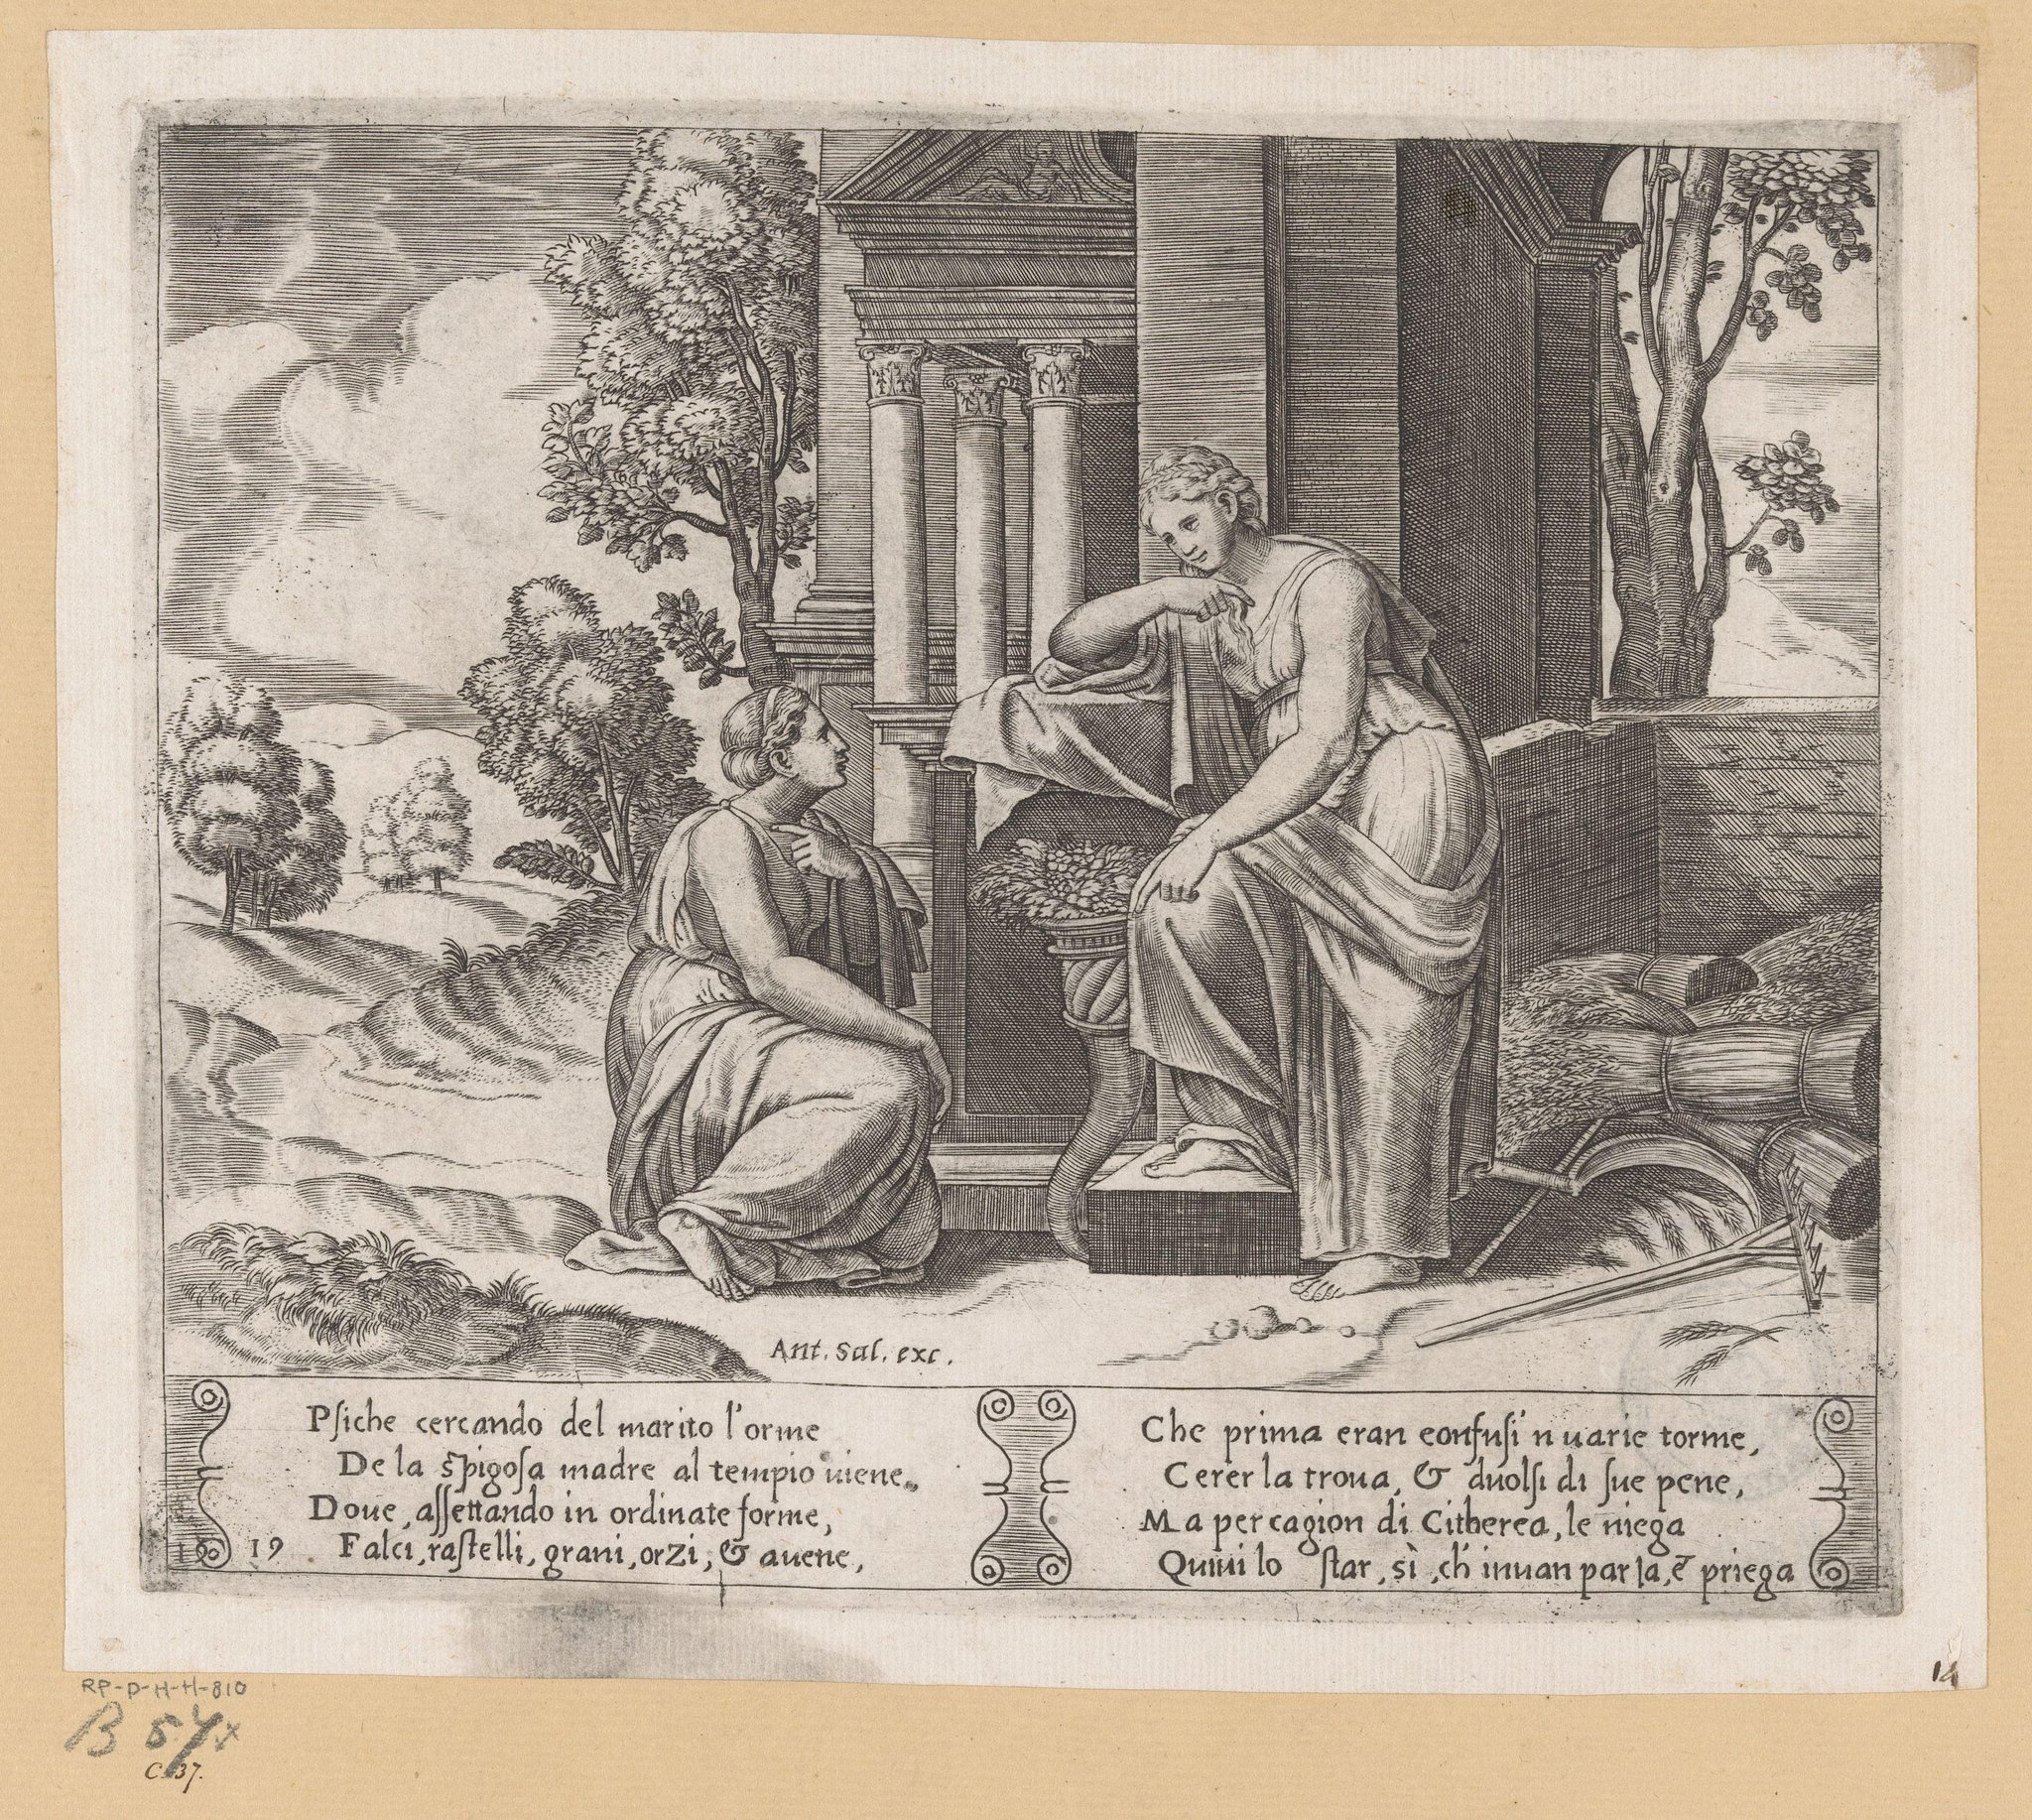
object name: print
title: Ceres weigert hulp aan Psyche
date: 1530-1560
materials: paper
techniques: engraving, intaglio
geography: rome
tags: city-view, and landscape with man-made constructions, 'cornucopia', horn of plenty, psyche with ceres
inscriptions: number: ‘14’, collector's mark: Lugt 10, collector's mark: ‘Hinloopen’, collector's mark: Lugt 11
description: Links de geknielde Psyche die aan de godin Ceres om hulp vraagt. Rechts staat Ceres met een hoorn des overvloeds, zeis, hark en korenaren. Italiaanse tekst in twee cartouches in ondermarge. Tweemaal genummerd linksonder: 19.